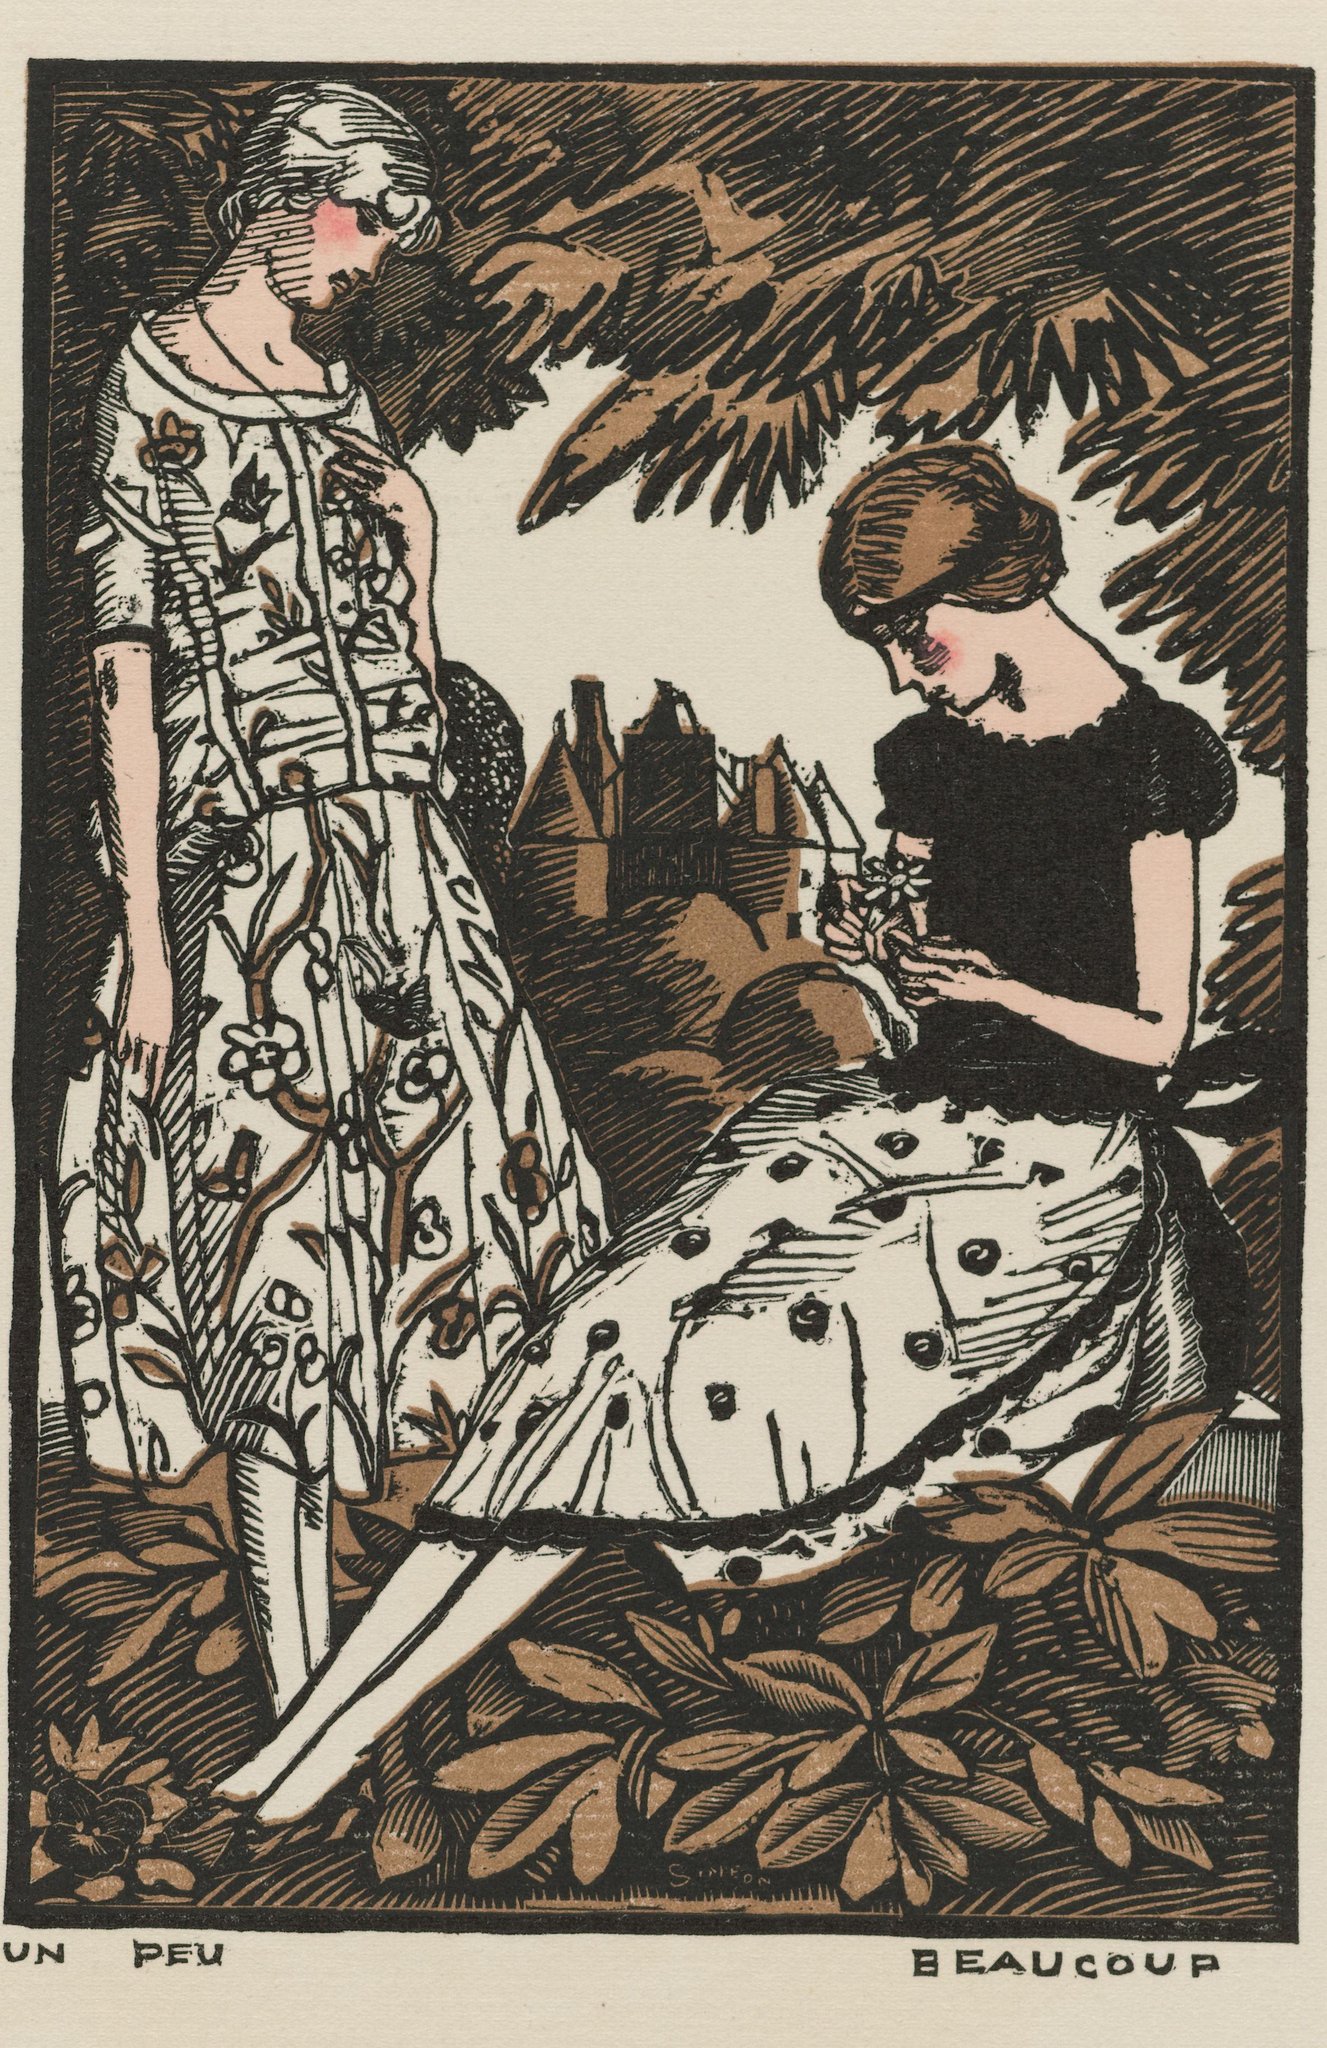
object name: fashion print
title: Gazette du Bon Ton, 1920 - No. 5, Pl. 34: Un peu beaucoup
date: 1920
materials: paper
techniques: hand coloring, letterpress printing, pochoir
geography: london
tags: picking flowers (+ variant), fashion plates, dress, gown (+ women's clothes), landscape with tower or castle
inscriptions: inscription: ‘Gazette du Bon Ton - No 5 / Juin 1920. - Pl. 34’, caption: ‘UN PEU BEAUCOUP’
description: Twee meisjes onder een boom, gekleed in resp. een witte japon met bloempatroon en een witte japon van mousseline met een zwart tafzijden lijfje. Planche 34 uit Gazette du Bon Ton 1920, No. 5. Uitleg over de kleding op pagina "Explication des Planches".